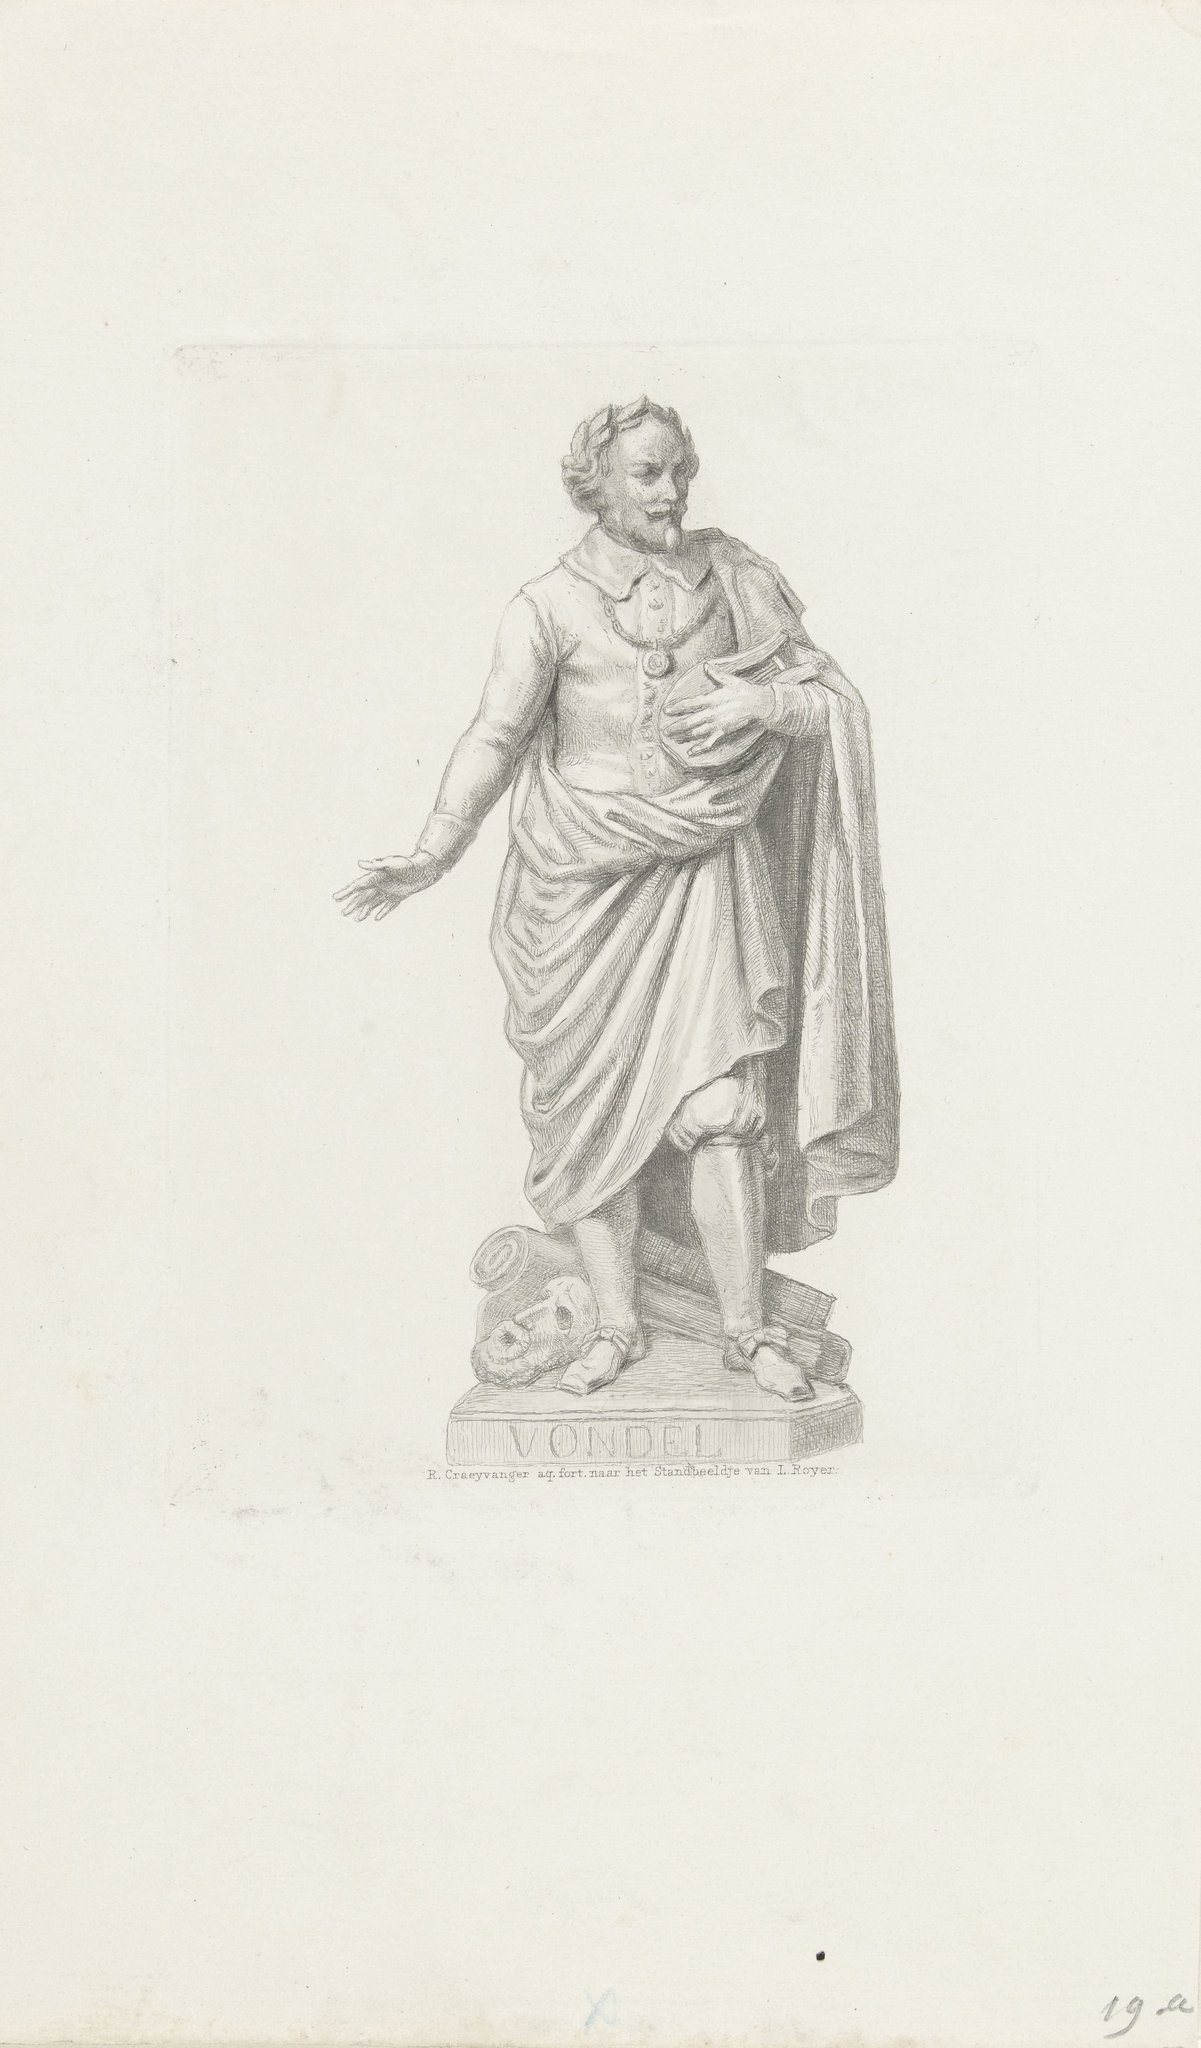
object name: print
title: Standbeeld van Joost van den Vondel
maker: reinier craeyvanger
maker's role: draughtsman, print maker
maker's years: 1812-1880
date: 1822-1880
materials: paper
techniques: etching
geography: amsterdam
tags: cologne, joost van den vondel, monument, statue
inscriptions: caption: ‘uit een dichtstate van W.I. Hofwijk’, collector's mark: Lugt 2228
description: Standbeeld van de dichter en toneelschrijver Joost van den Vondel. Hij staat met het hoofd naar rechts gewend, de rechterhand uitgestrekt. In de linkerarm een lier. Vondel is gekroond met een laurierkrans. Op de grond naast hem een toneelmasker, twee boeken en een rol.